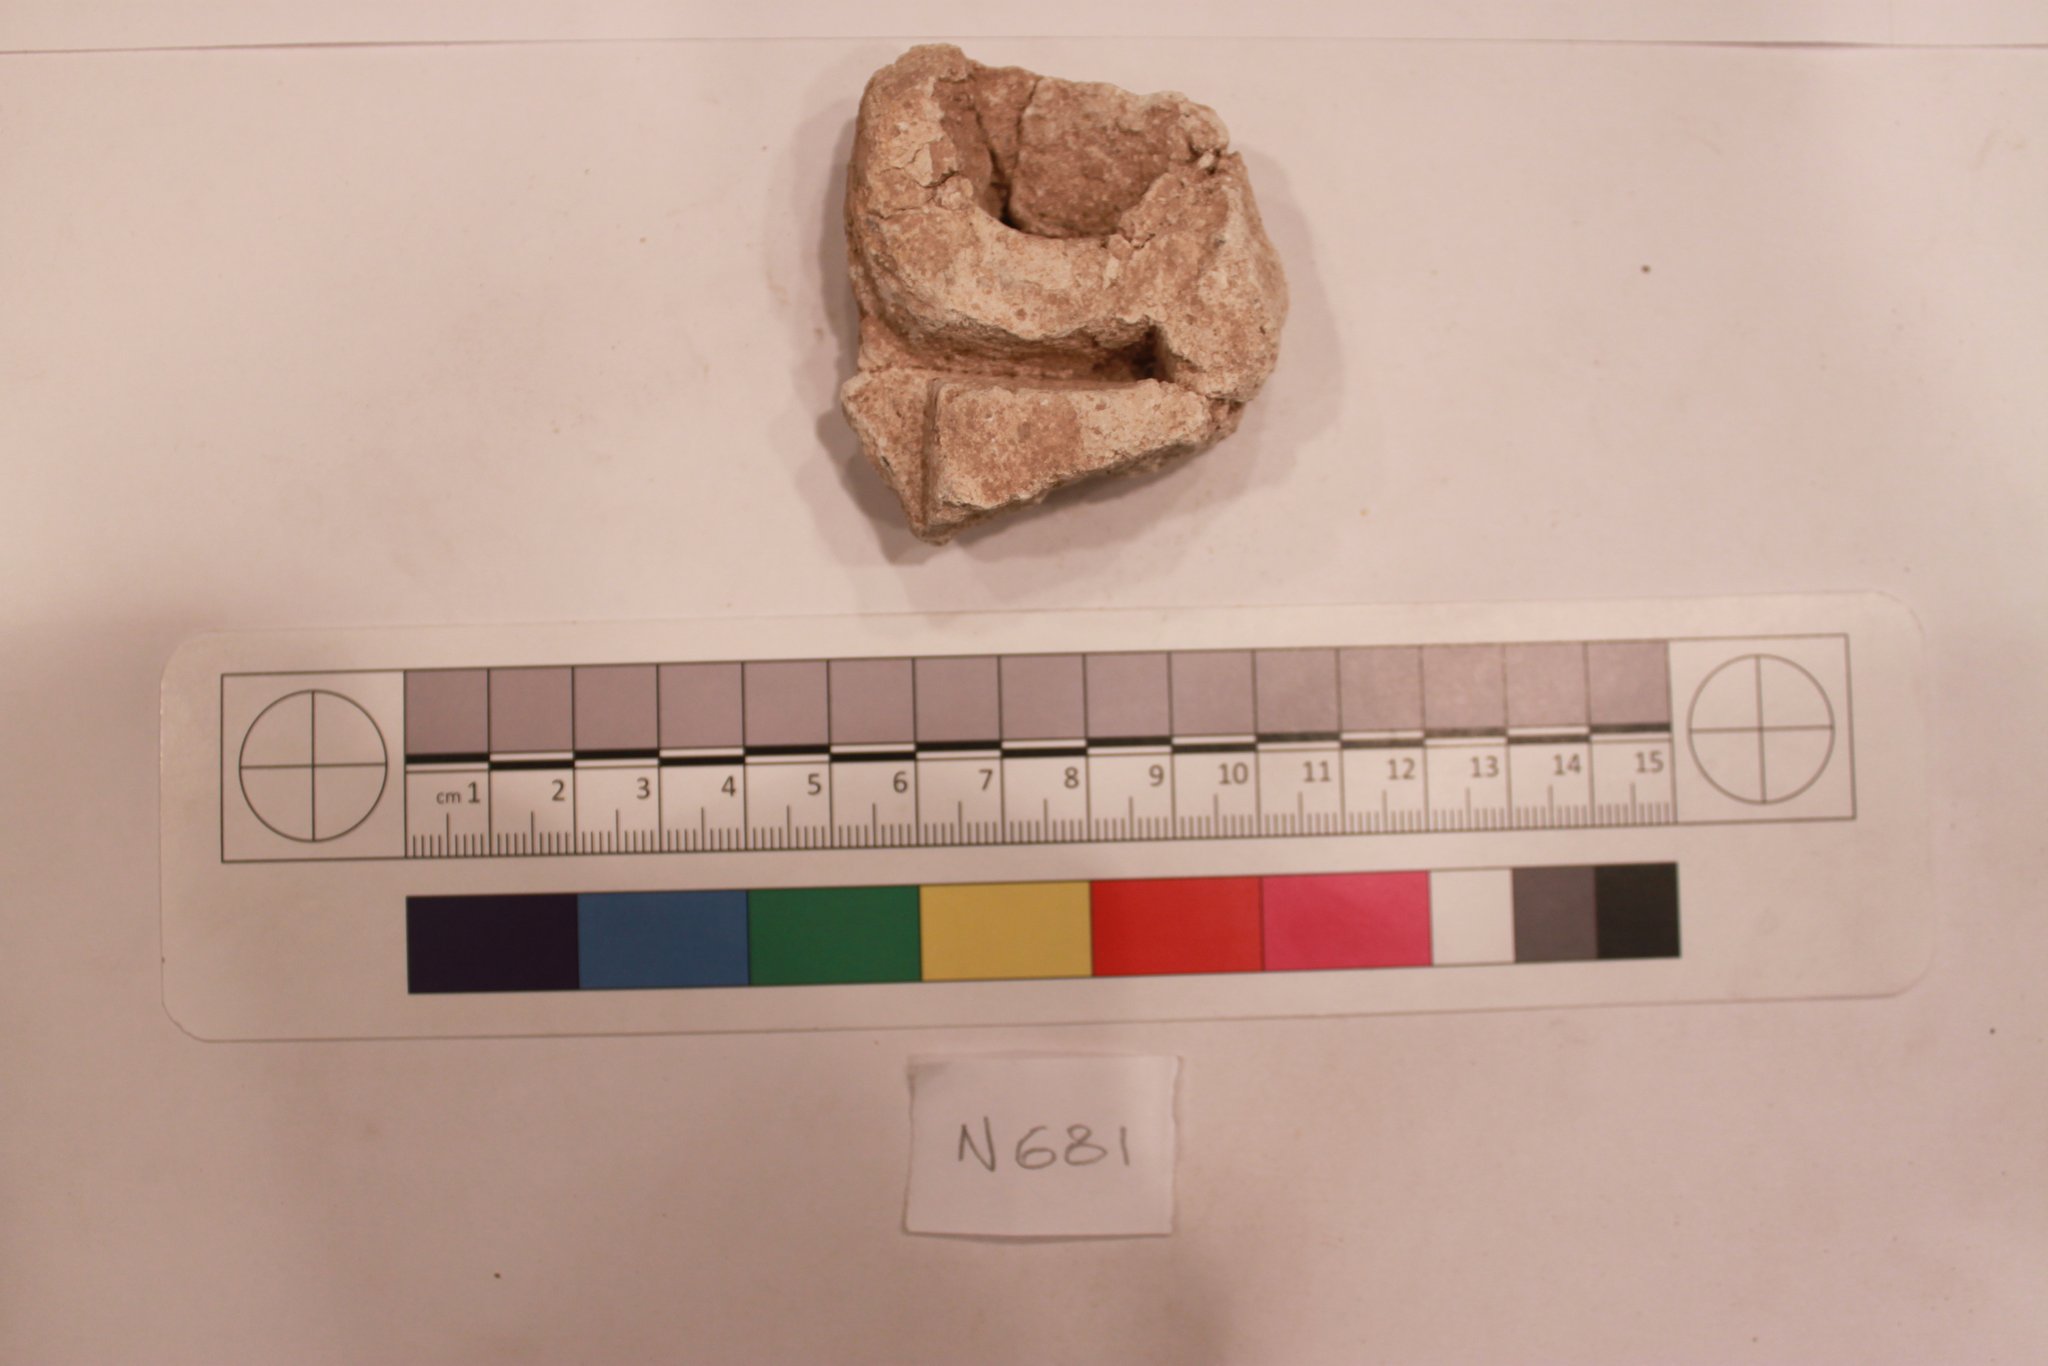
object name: fragment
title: Stucco Fragment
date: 701-1200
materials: plaster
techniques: carving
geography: iran